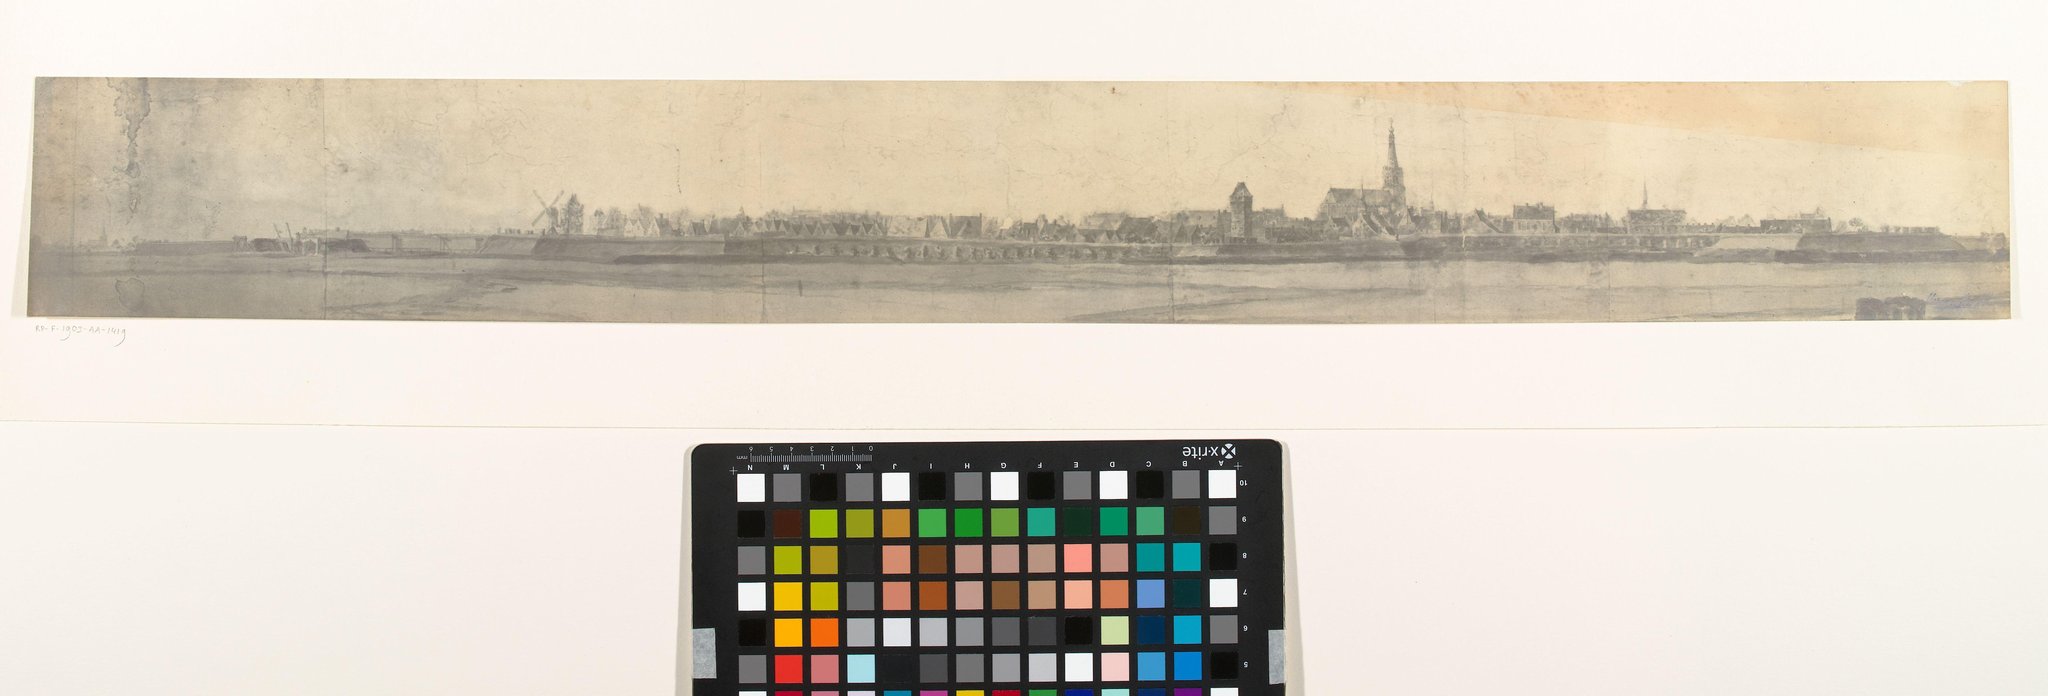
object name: photograph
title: Gezicht op Doesburg, 1672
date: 1900-1903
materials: paper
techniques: gelatin silver print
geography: france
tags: lodewijk xiv (koning van frankrijk), city-view, and landscape with man-made constructions, rampjaar (disaster year)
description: Niet in Frederik Muller; door het RPK toegevoegd nummer. Onderdeel van een groep van ca. 50 foto's van tekeningen van de Franse inval in de Nederlanden in 1672 door Adam Frans van der Meulen, bewaard in de Manufacture Nationale des Gobelins te Parijs.